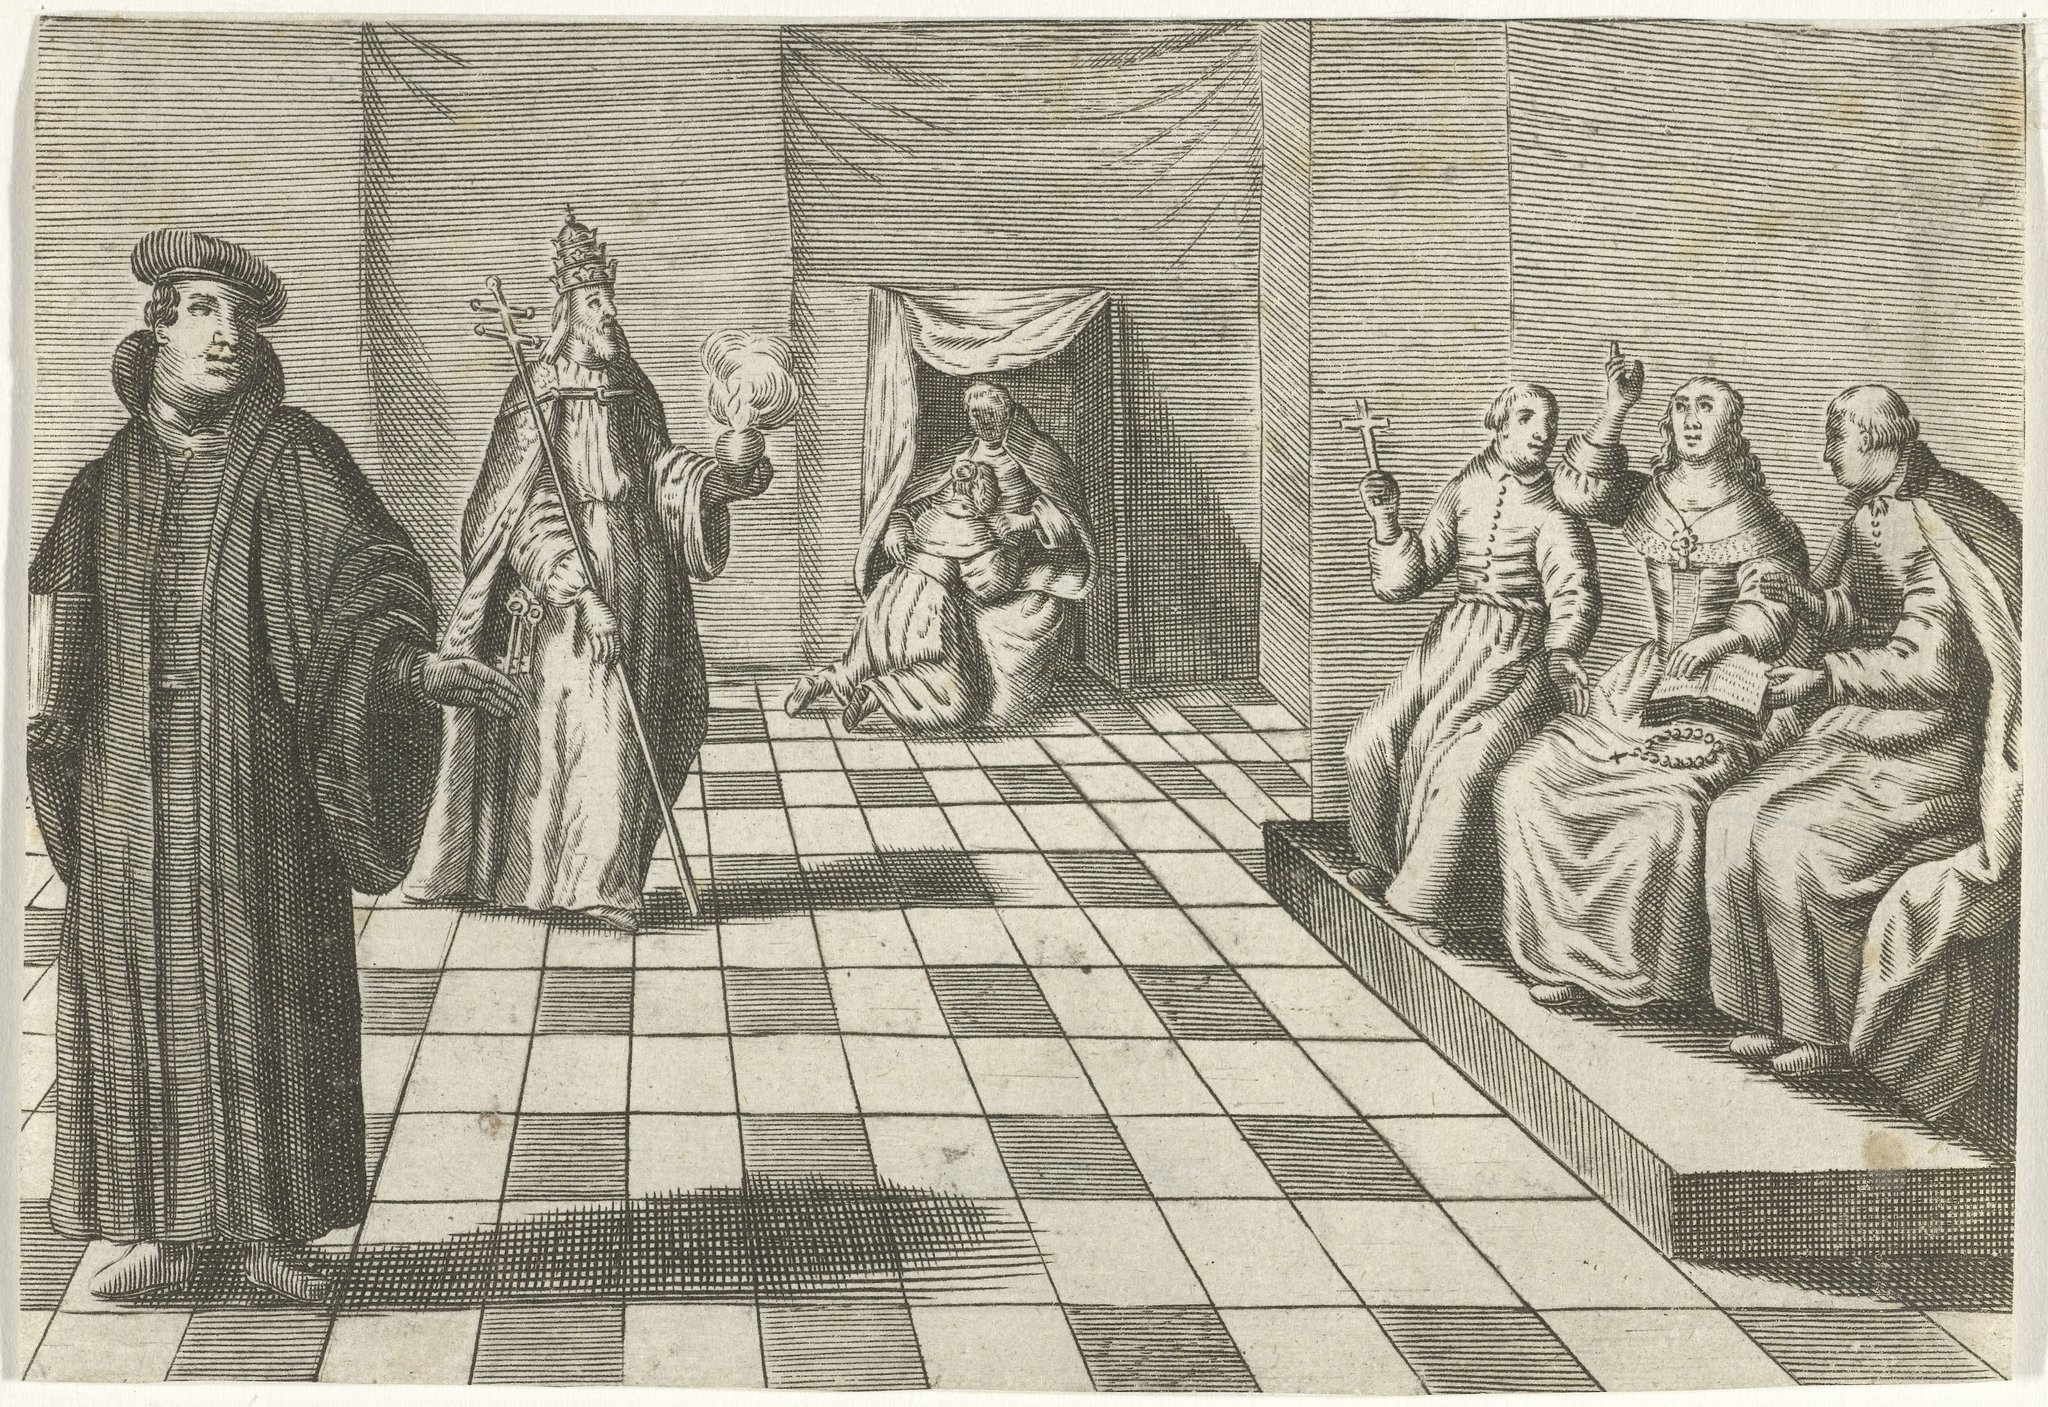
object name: print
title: Interieur met geestelijken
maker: christiaan hagen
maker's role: draughtsman, print maker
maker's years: 1635-1707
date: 1663-1695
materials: paper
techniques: engraving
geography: amsterdam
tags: augustine, bishop of hippo; possible attributes: arrows piercing his breast, book, child with spoon, flaming heart, heart (pierced with arrows), pen, cross as symbol of christ, insignia of bishop, e.g. mitre, crozier, interior ~ representation of a building, index finger forwards, pointing, indicating, pavement, floor ~ architecture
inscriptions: collector's mark: Lugt 2228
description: Een interieur met rechts drie figuren op een verhoging, waaronder een vrouw die omhoog wijst. Links staat een man met een boek en achter hem een bisschop, voorstellende Augustinus van Hippo, met tiara, staf en in zijn linkerhand een brandend hart. Achterin een knielende vrouw bij een biechtvader.